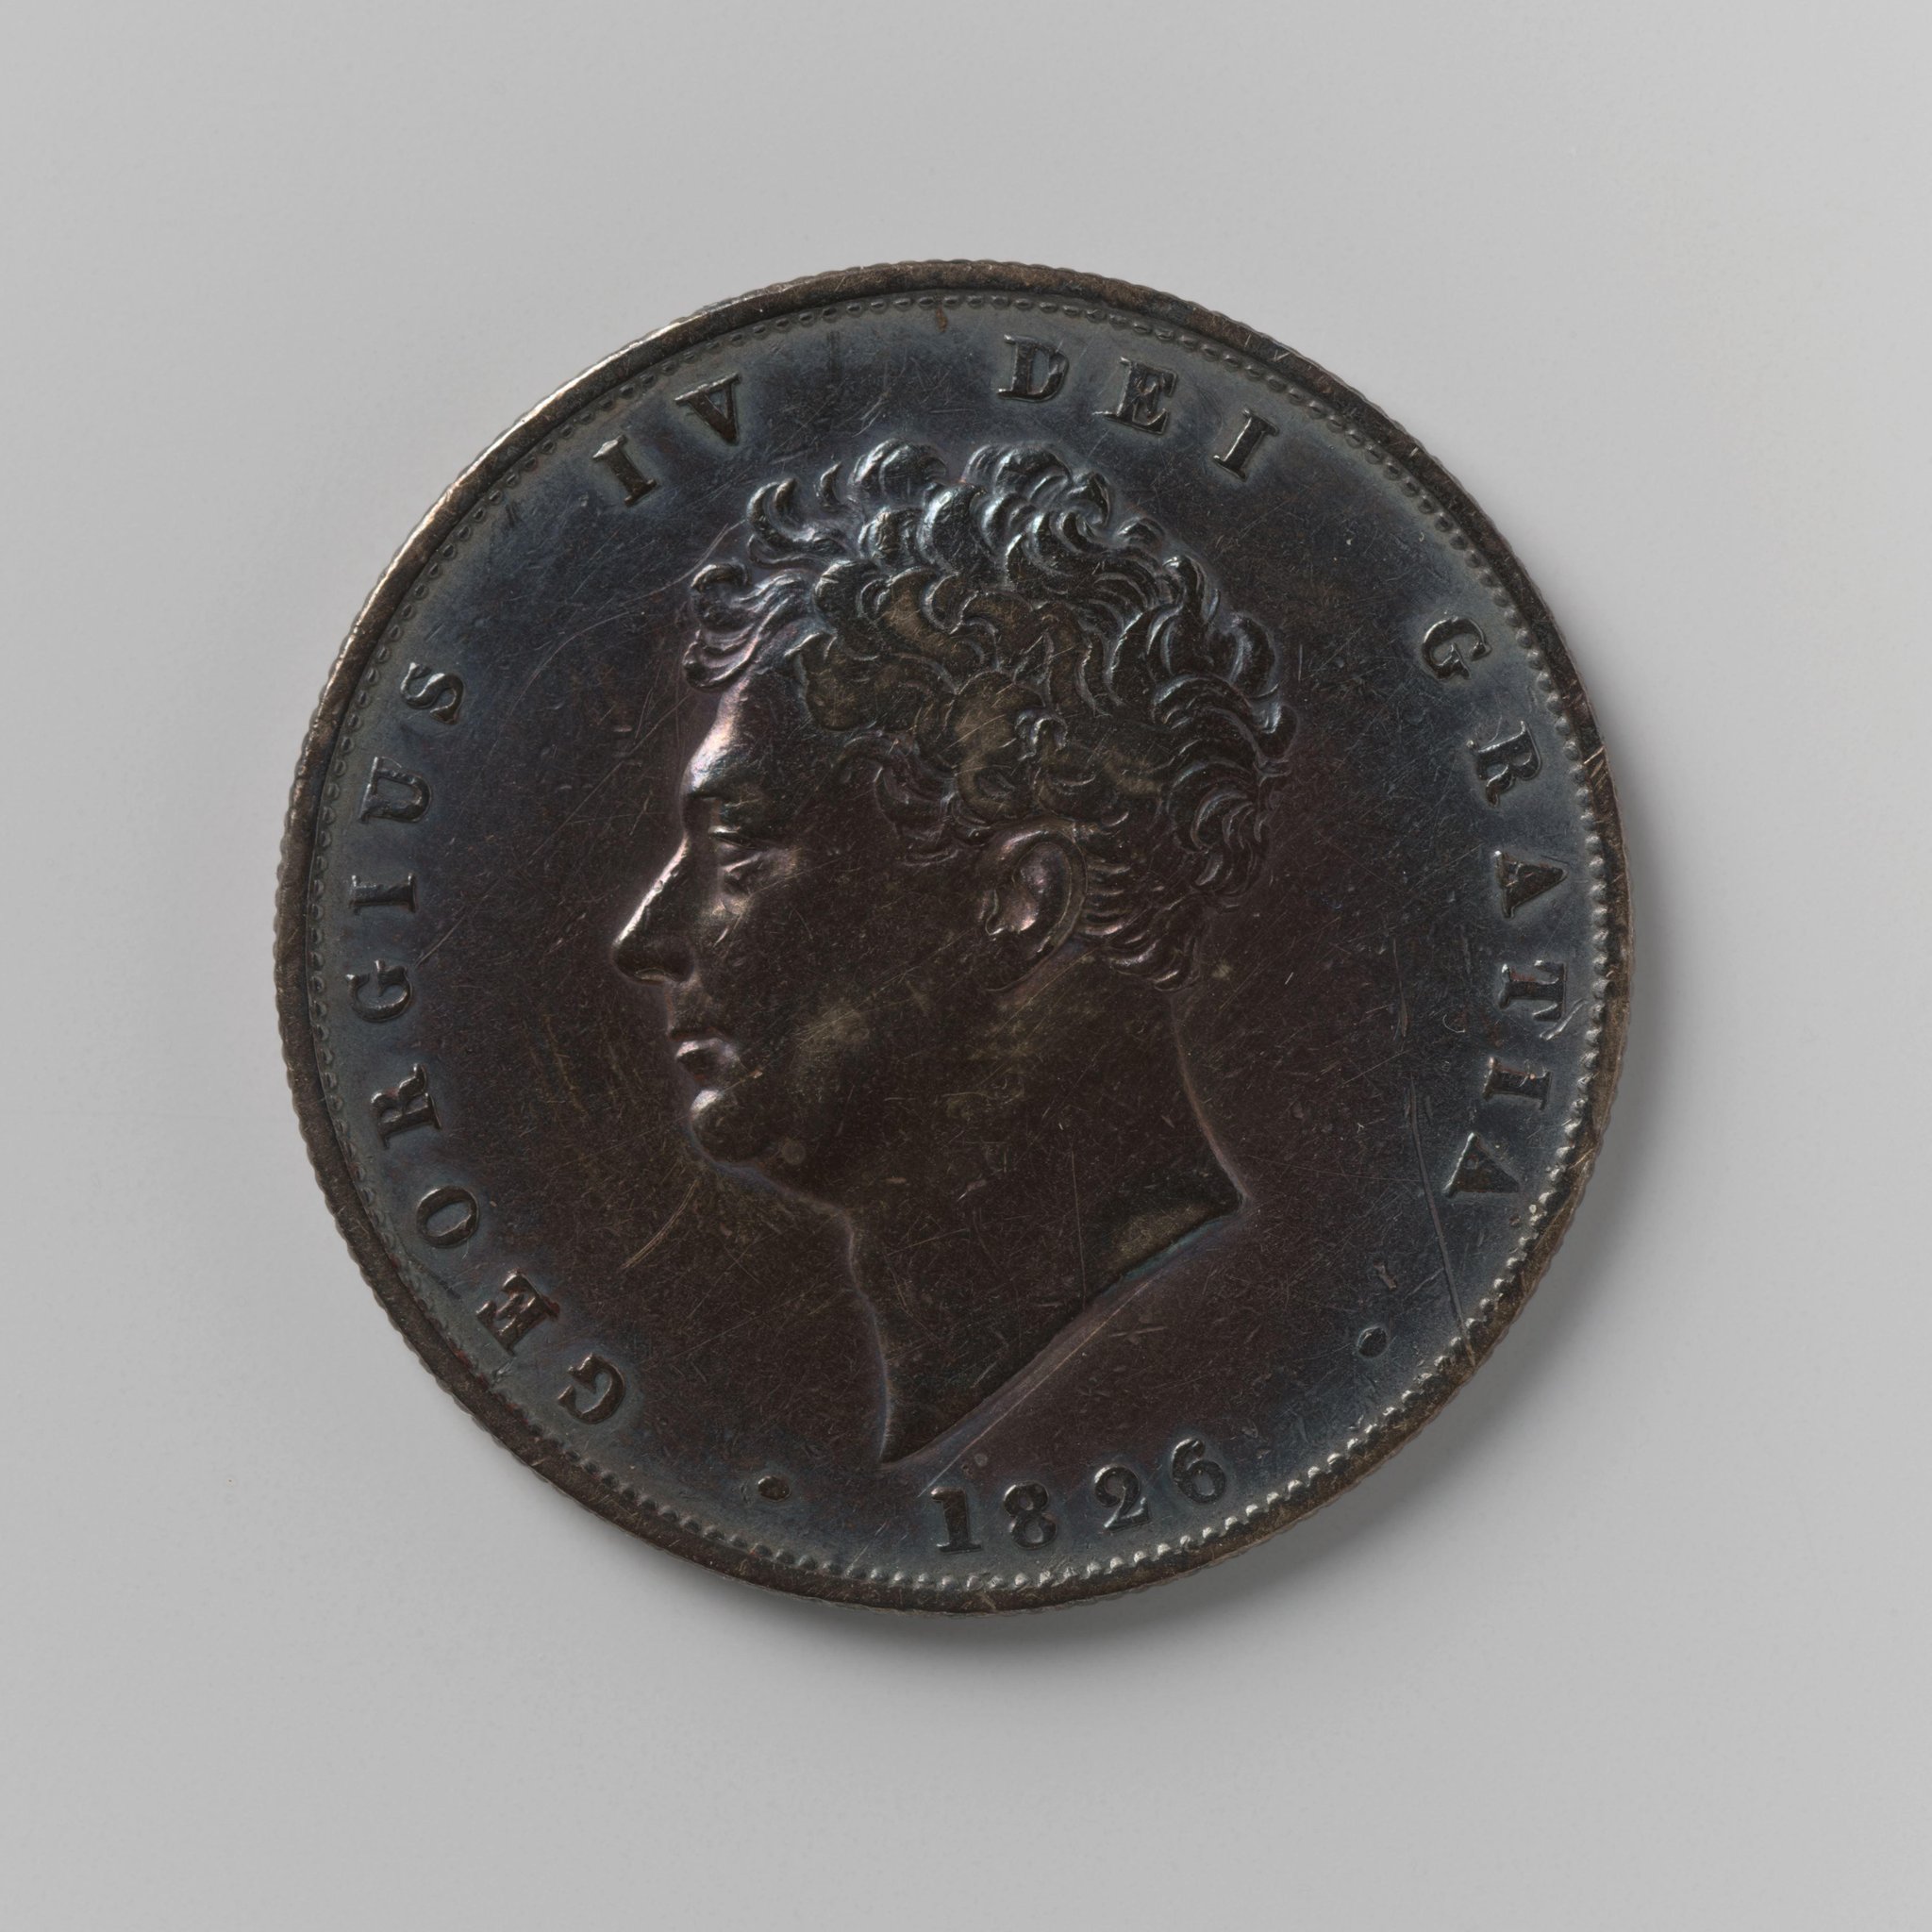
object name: coin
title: Engeland, George IV, ½ crown, 1826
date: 1826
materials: silver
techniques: striking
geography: london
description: Zilveren munt. Voorzijde: hoofd van de koning naar links. Jaartal onderaan. Keerzijde: gekroond wapenschild met helmteken en wapenspreuk. Kartelrand.